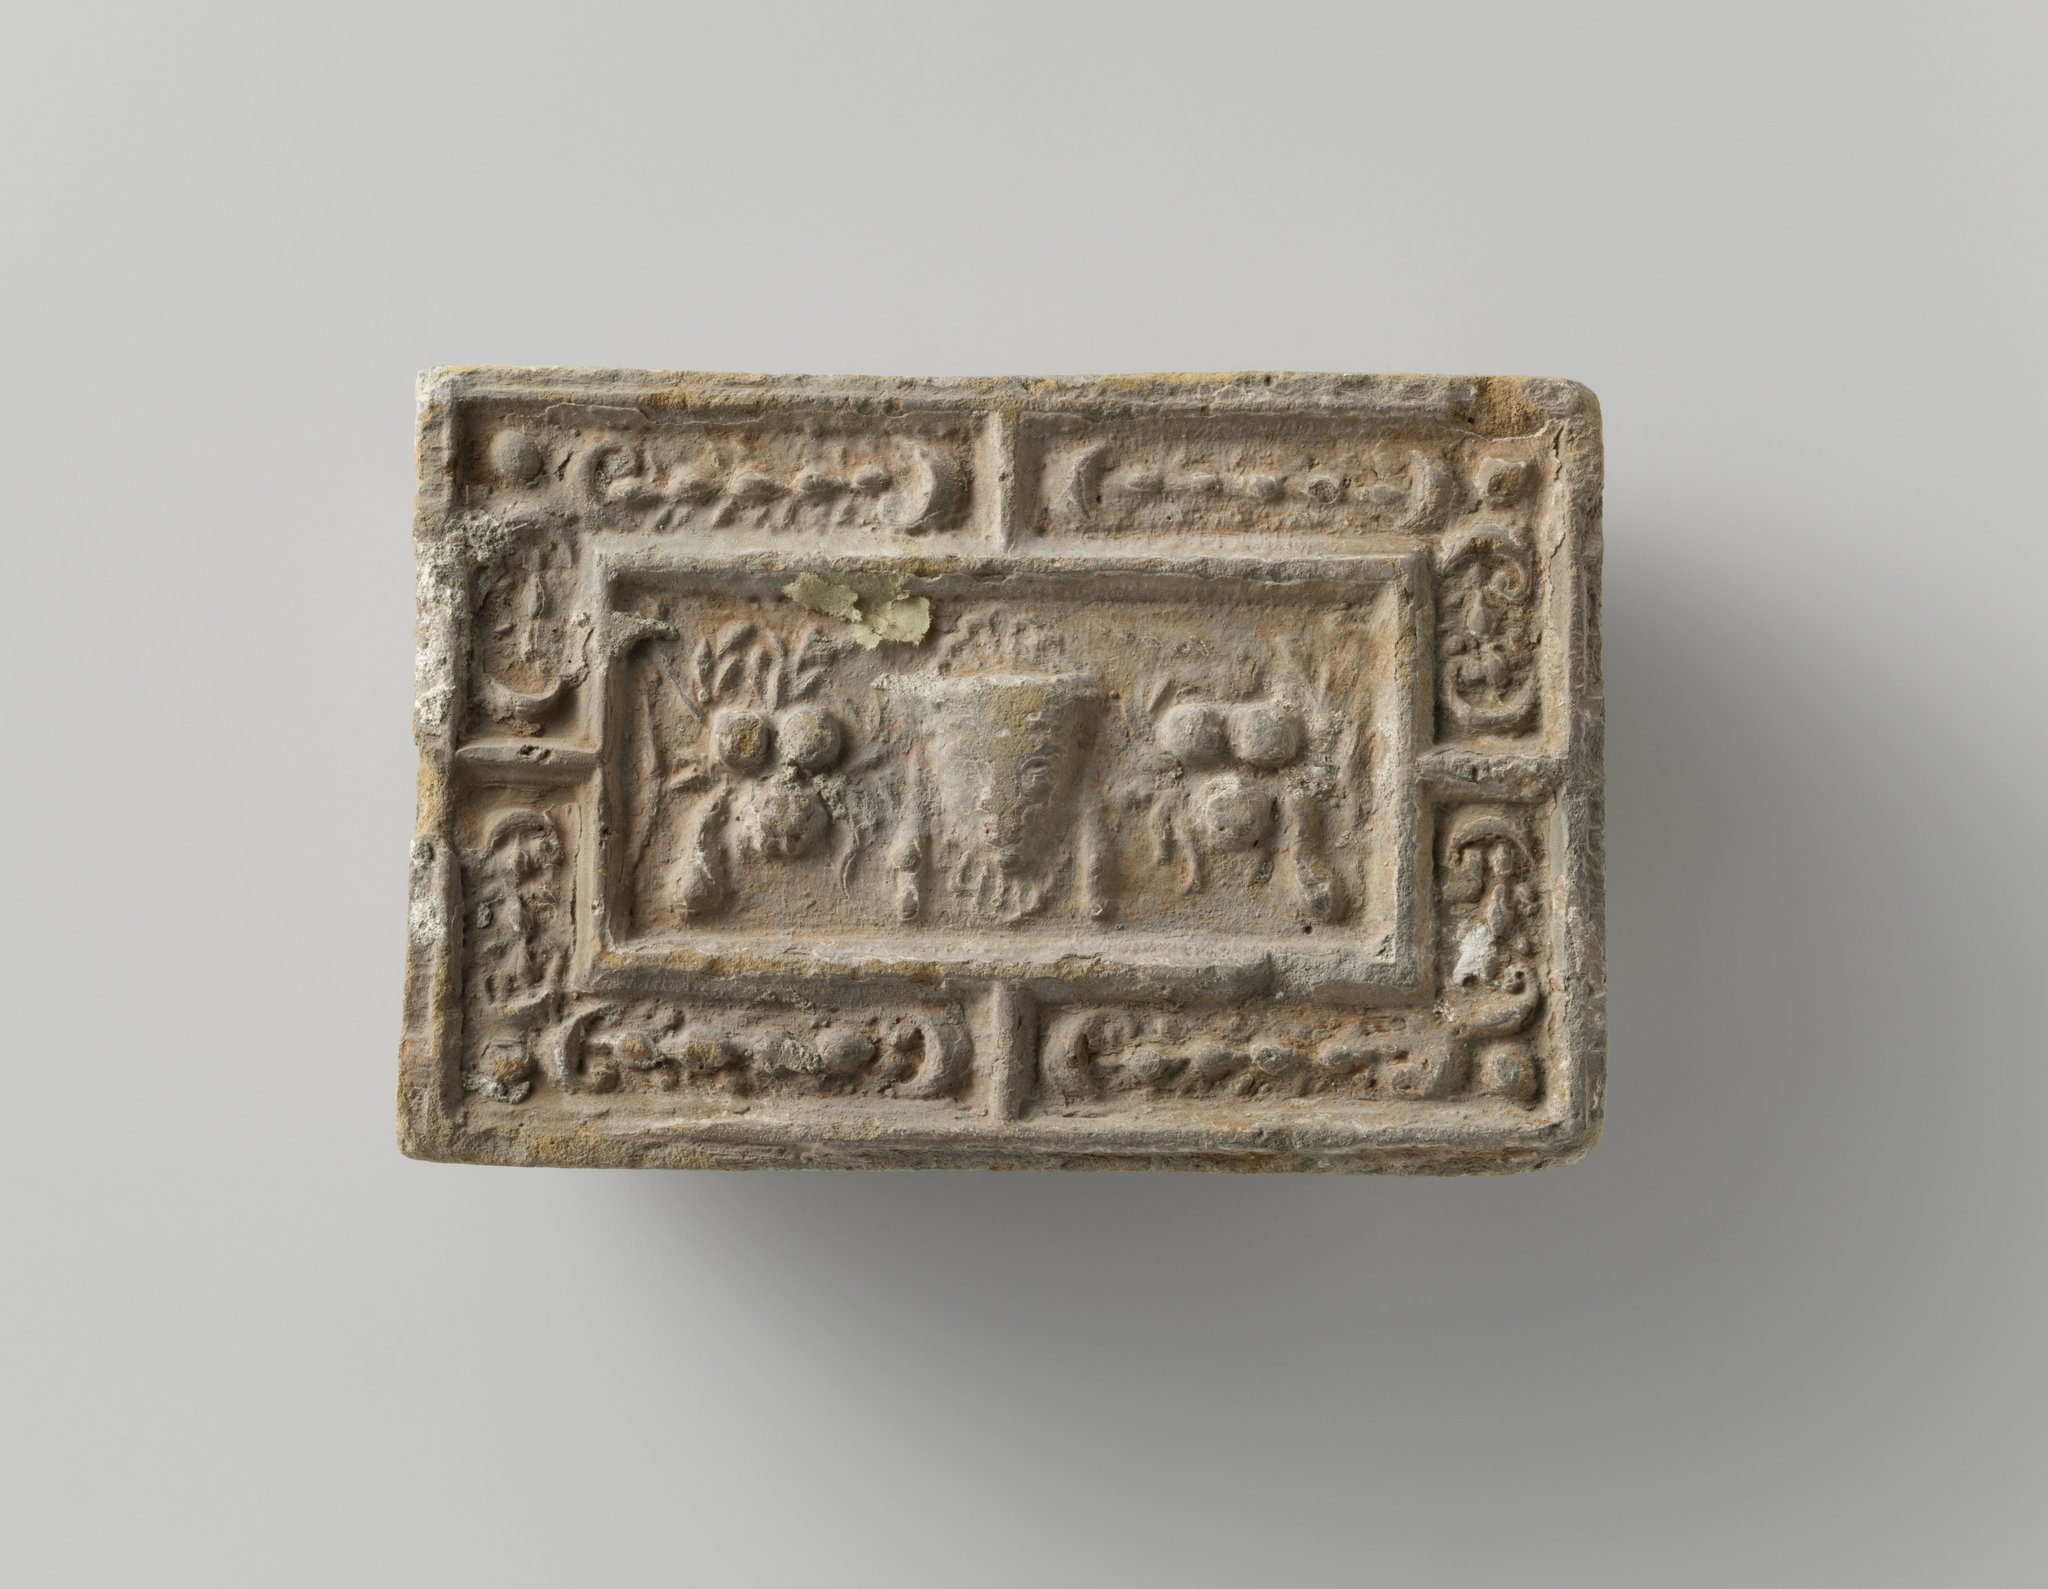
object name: hearthstone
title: Haardsteen met voorstelling van een mascaron tussen twee vruchtfestoenen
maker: Anonymous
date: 1575-1600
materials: earthenware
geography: antwerp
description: Haardsteen van gebakken aarde, met een langwerpig vierkante cartouche waarin een mascaron en guirlanden van vruchten en daaromheen een doorlopende guirlande.